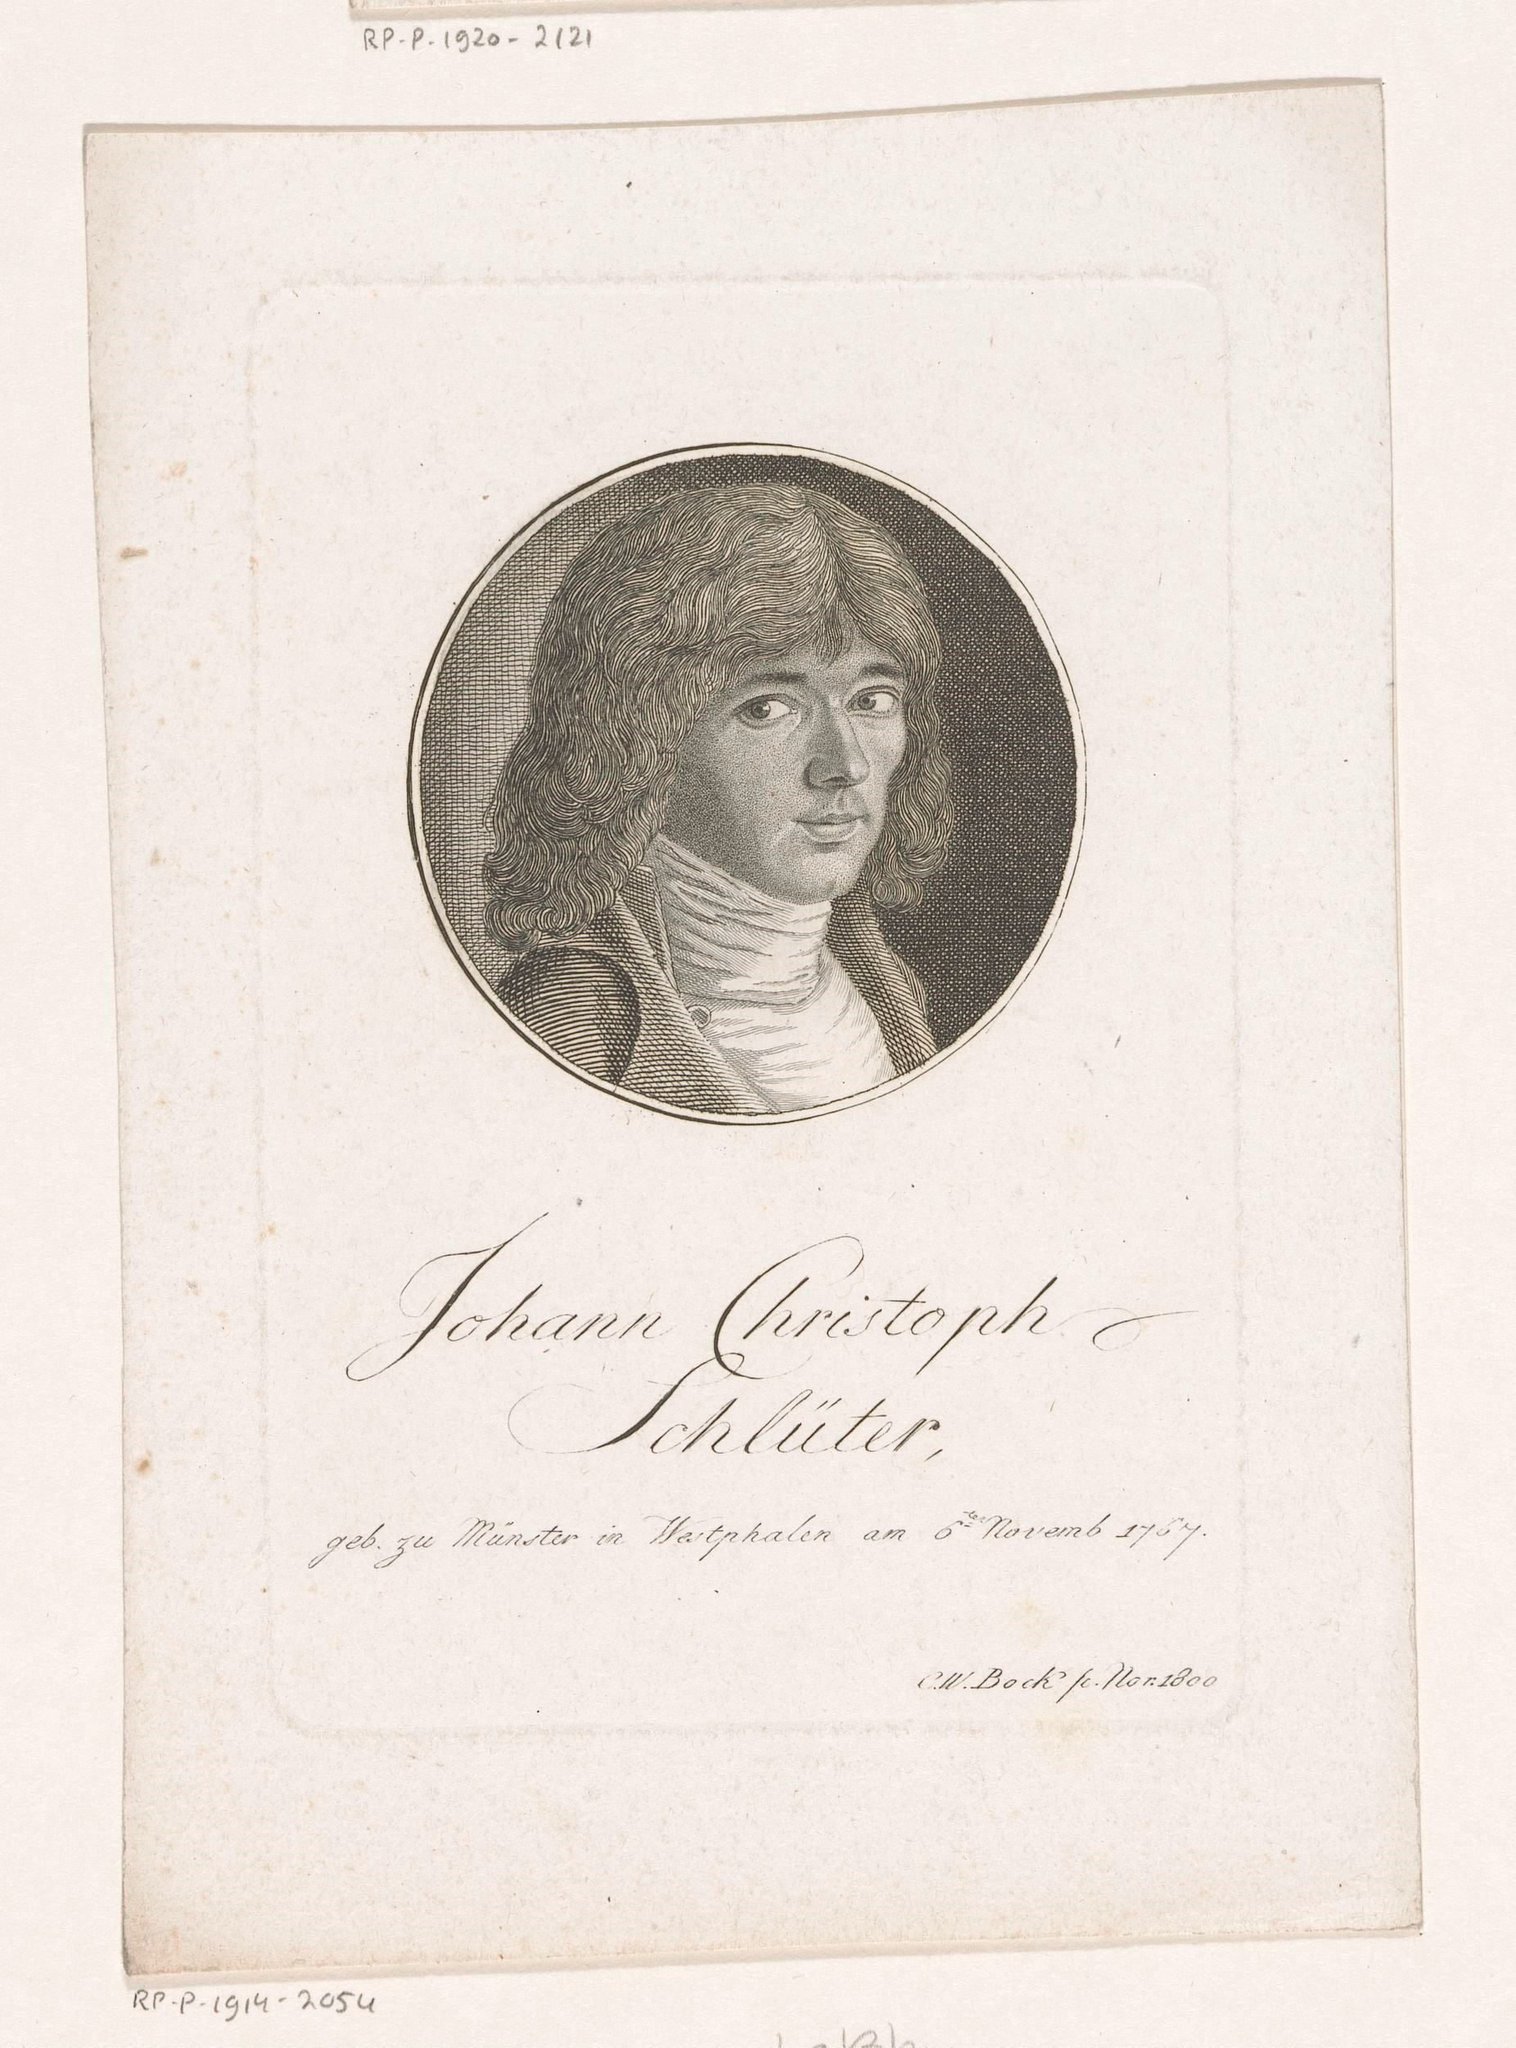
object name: print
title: Portret van Johann Christoph Schlüter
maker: christoph wilhelm bock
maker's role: print maker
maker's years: 1755-1836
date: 1800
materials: paper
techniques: engraving, etching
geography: nuremberg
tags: historical persons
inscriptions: collector's mark: Lugt 2228